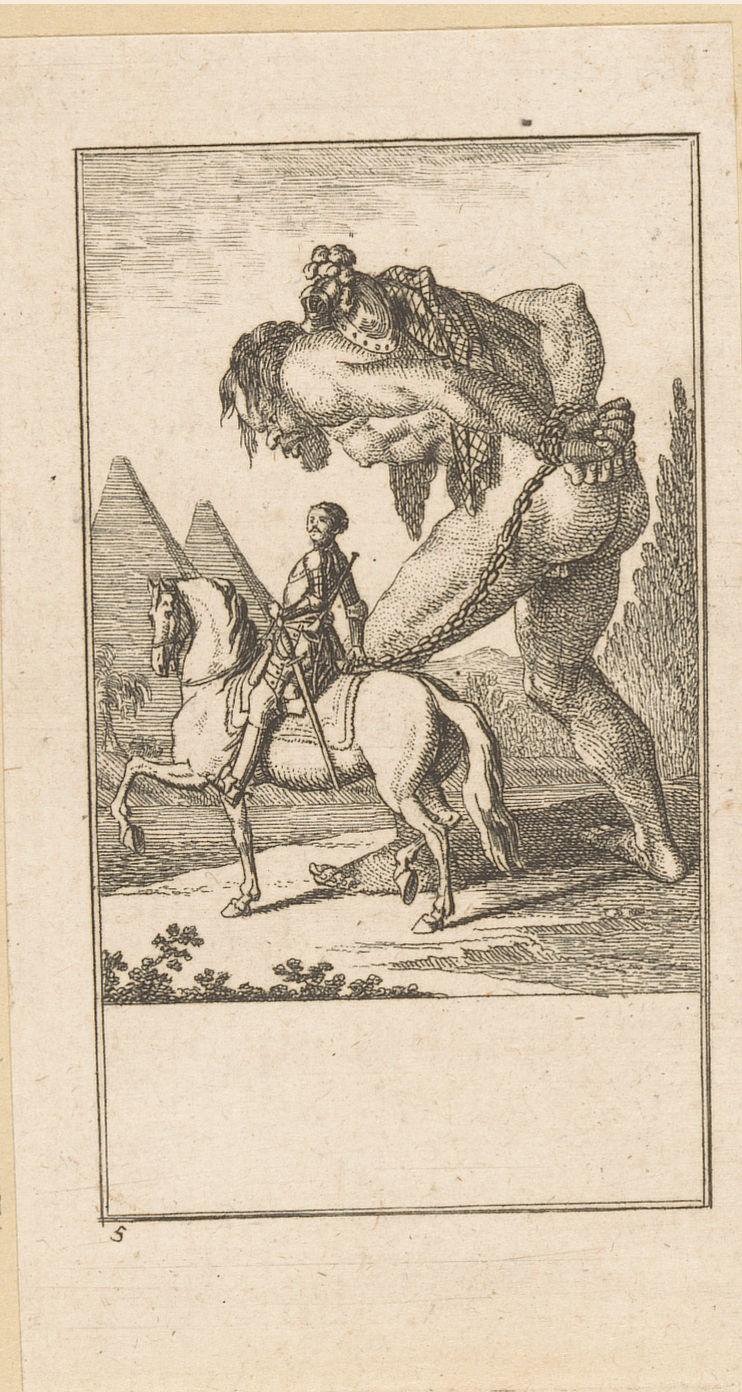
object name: print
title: Astolfo houdt Calligorant als gevangene aan zijn zijde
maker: louis wilhelm chodowiecki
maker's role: print maker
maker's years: 1765-1805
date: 1771-1772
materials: paper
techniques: etching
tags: imprisonment, pyramid (marking grave), (scenes from) specific works of literature: ariosto, orlando furioso, giants, colossi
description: Vervaardigd voor Orlando Furioso van Ludovico Ariosto. Prent gebruikt voor: Almanac Genealogique pour l'année 1772. Berlijn: s.n.s.a.